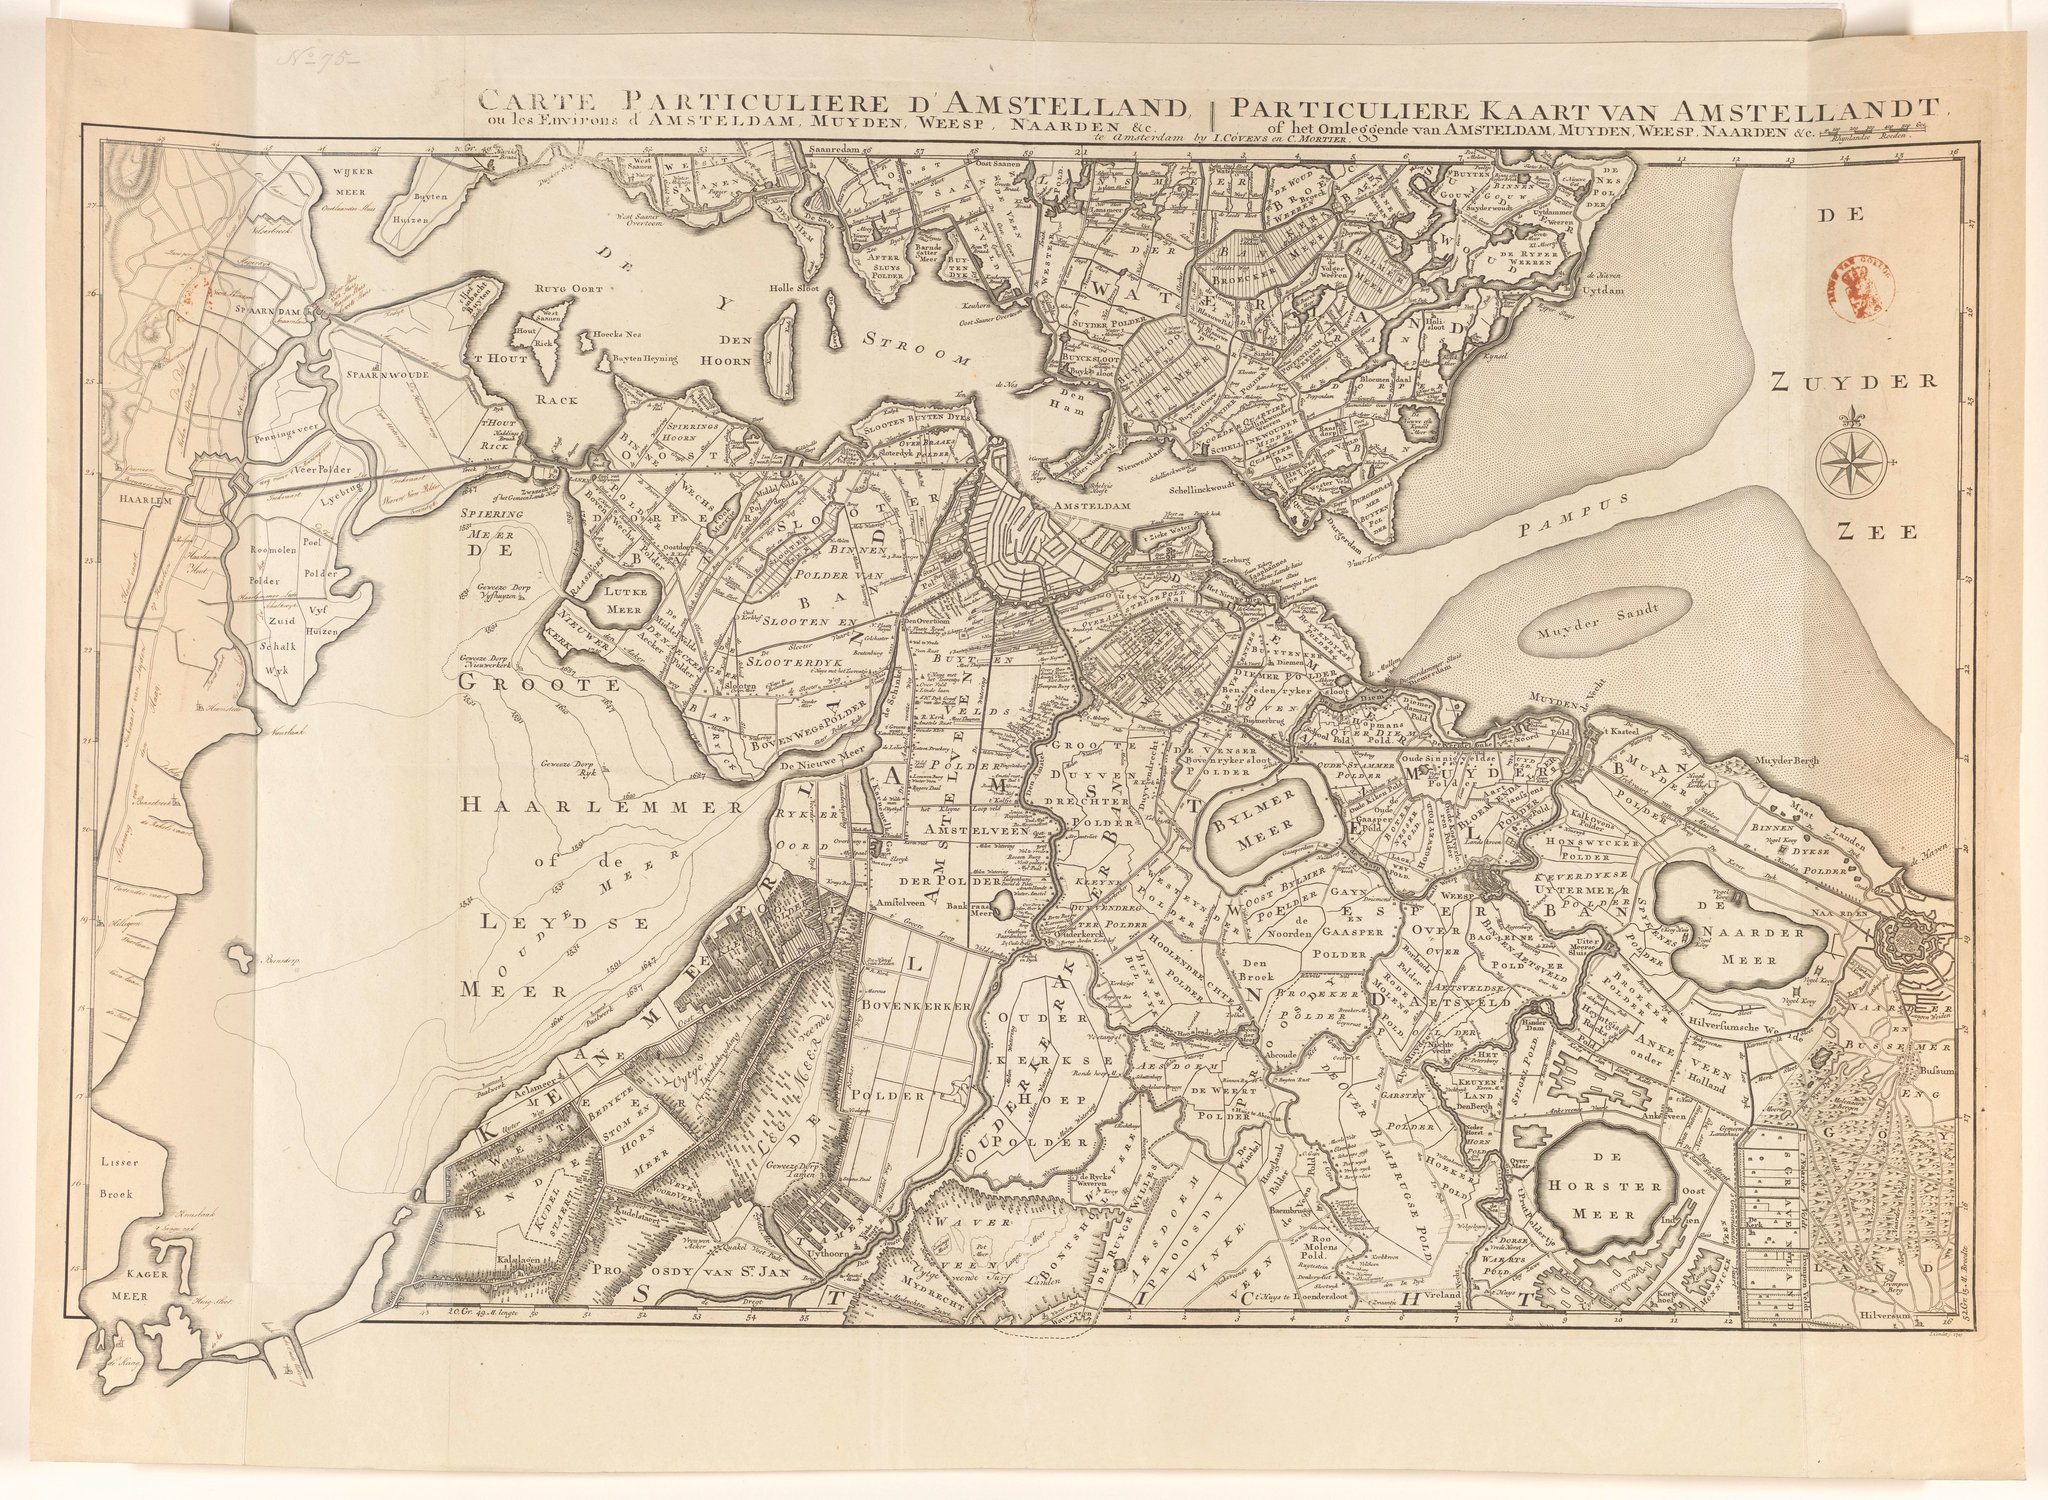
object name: print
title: Particuliere kaart van Amstellandt, of het omleggende van Amsteldam, Muyden, Weesp, Naarden &c. / Carte particuliere d'Amstelland , ou les environs d'Amsteldam, Muyden, Weesp, Naarden &c.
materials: ink, paper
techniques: brush, engraving, pen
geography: amsterdam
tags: maps of separate countries or regions, amsterdam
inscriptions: collector's mark: Lugt 19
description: Deze kaart is gedrukt van twee platen en deels met de hand getekend. Het grootste deel van de kaart is gedrukt van een plaat die in 1749 werd gegraveerd door Johannes Condet (zie RP-P-AO-72-2 en RP-P-AO-8-72-1). Op de huidige kaart is de linkerrand van deze plaat opgeschuurd voordat de plaat werd gedrukt. Vervolgens is het linkerdeel van de huidige kaart toegevoegd. Dit stuk is deels van een nieuwe plaat gedrukt en deels met penseel en pen bijgetekend. De eerste staat van de rechterplaat is ook gebruikt in: Atlas nouveau, contenant toutes les parties du monde, ou sont exactement remarquées les empires, monarchies, royaumes, etats, republiques &c. (…). Amsterdam: Covens & Mortier, s.a. [na 1757].